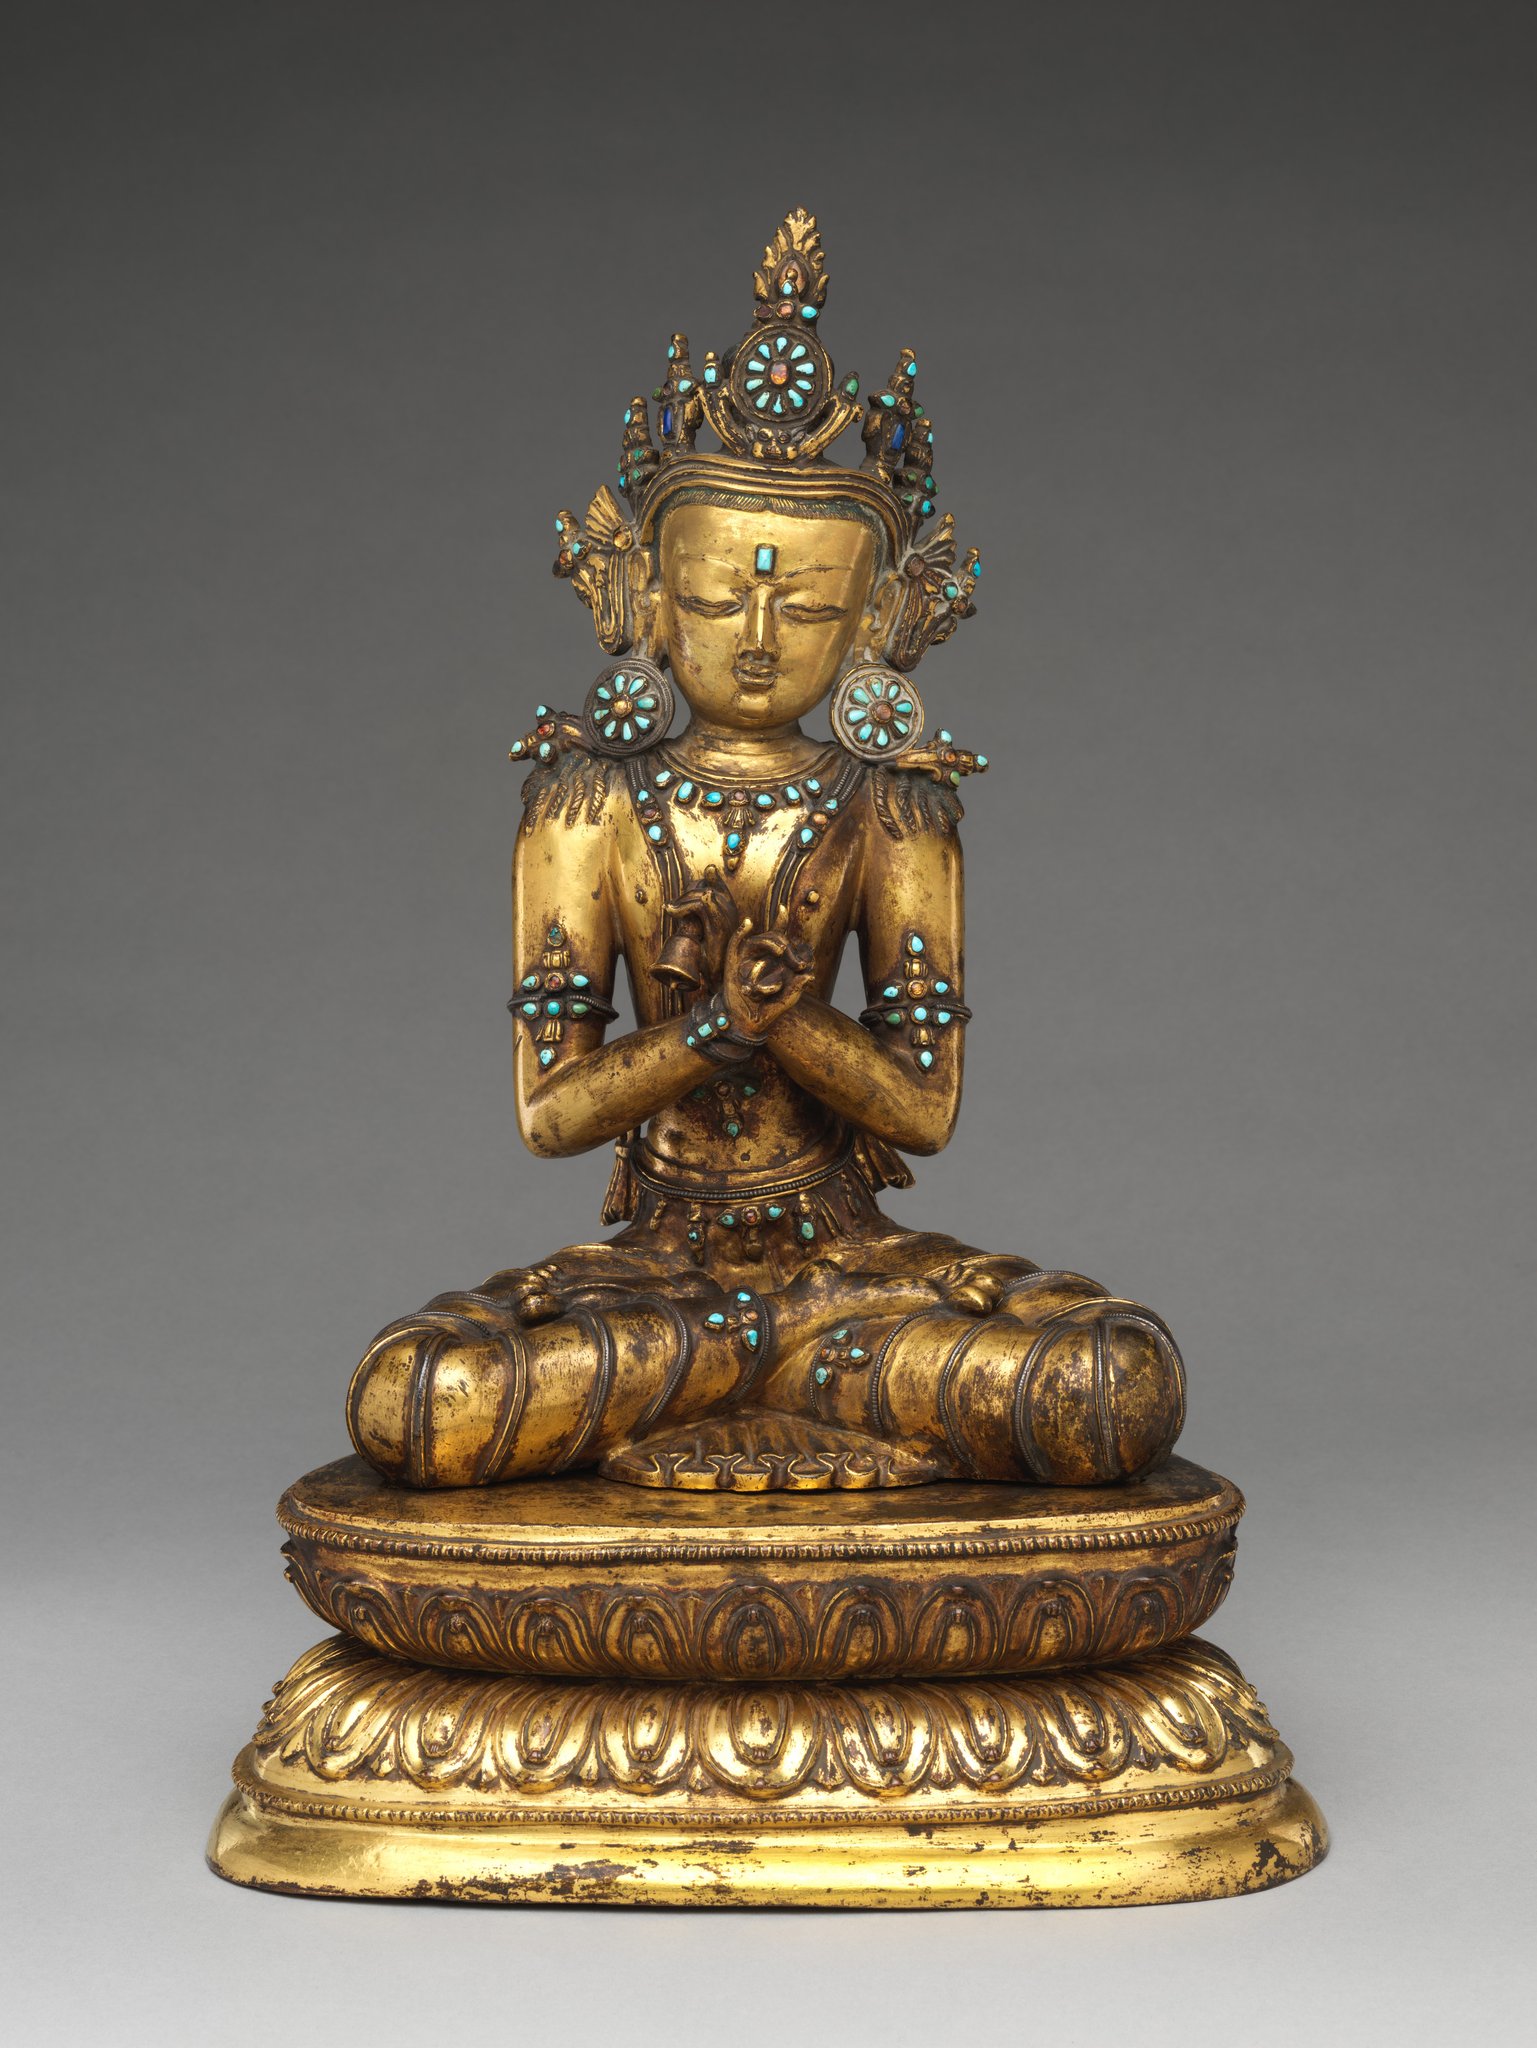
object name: figure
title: The Primordial Buddha Vajradhara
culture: tibetan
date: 1401-1500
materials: copper alloy, gilt, silver, stone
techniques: inlay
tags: bodhisattvas